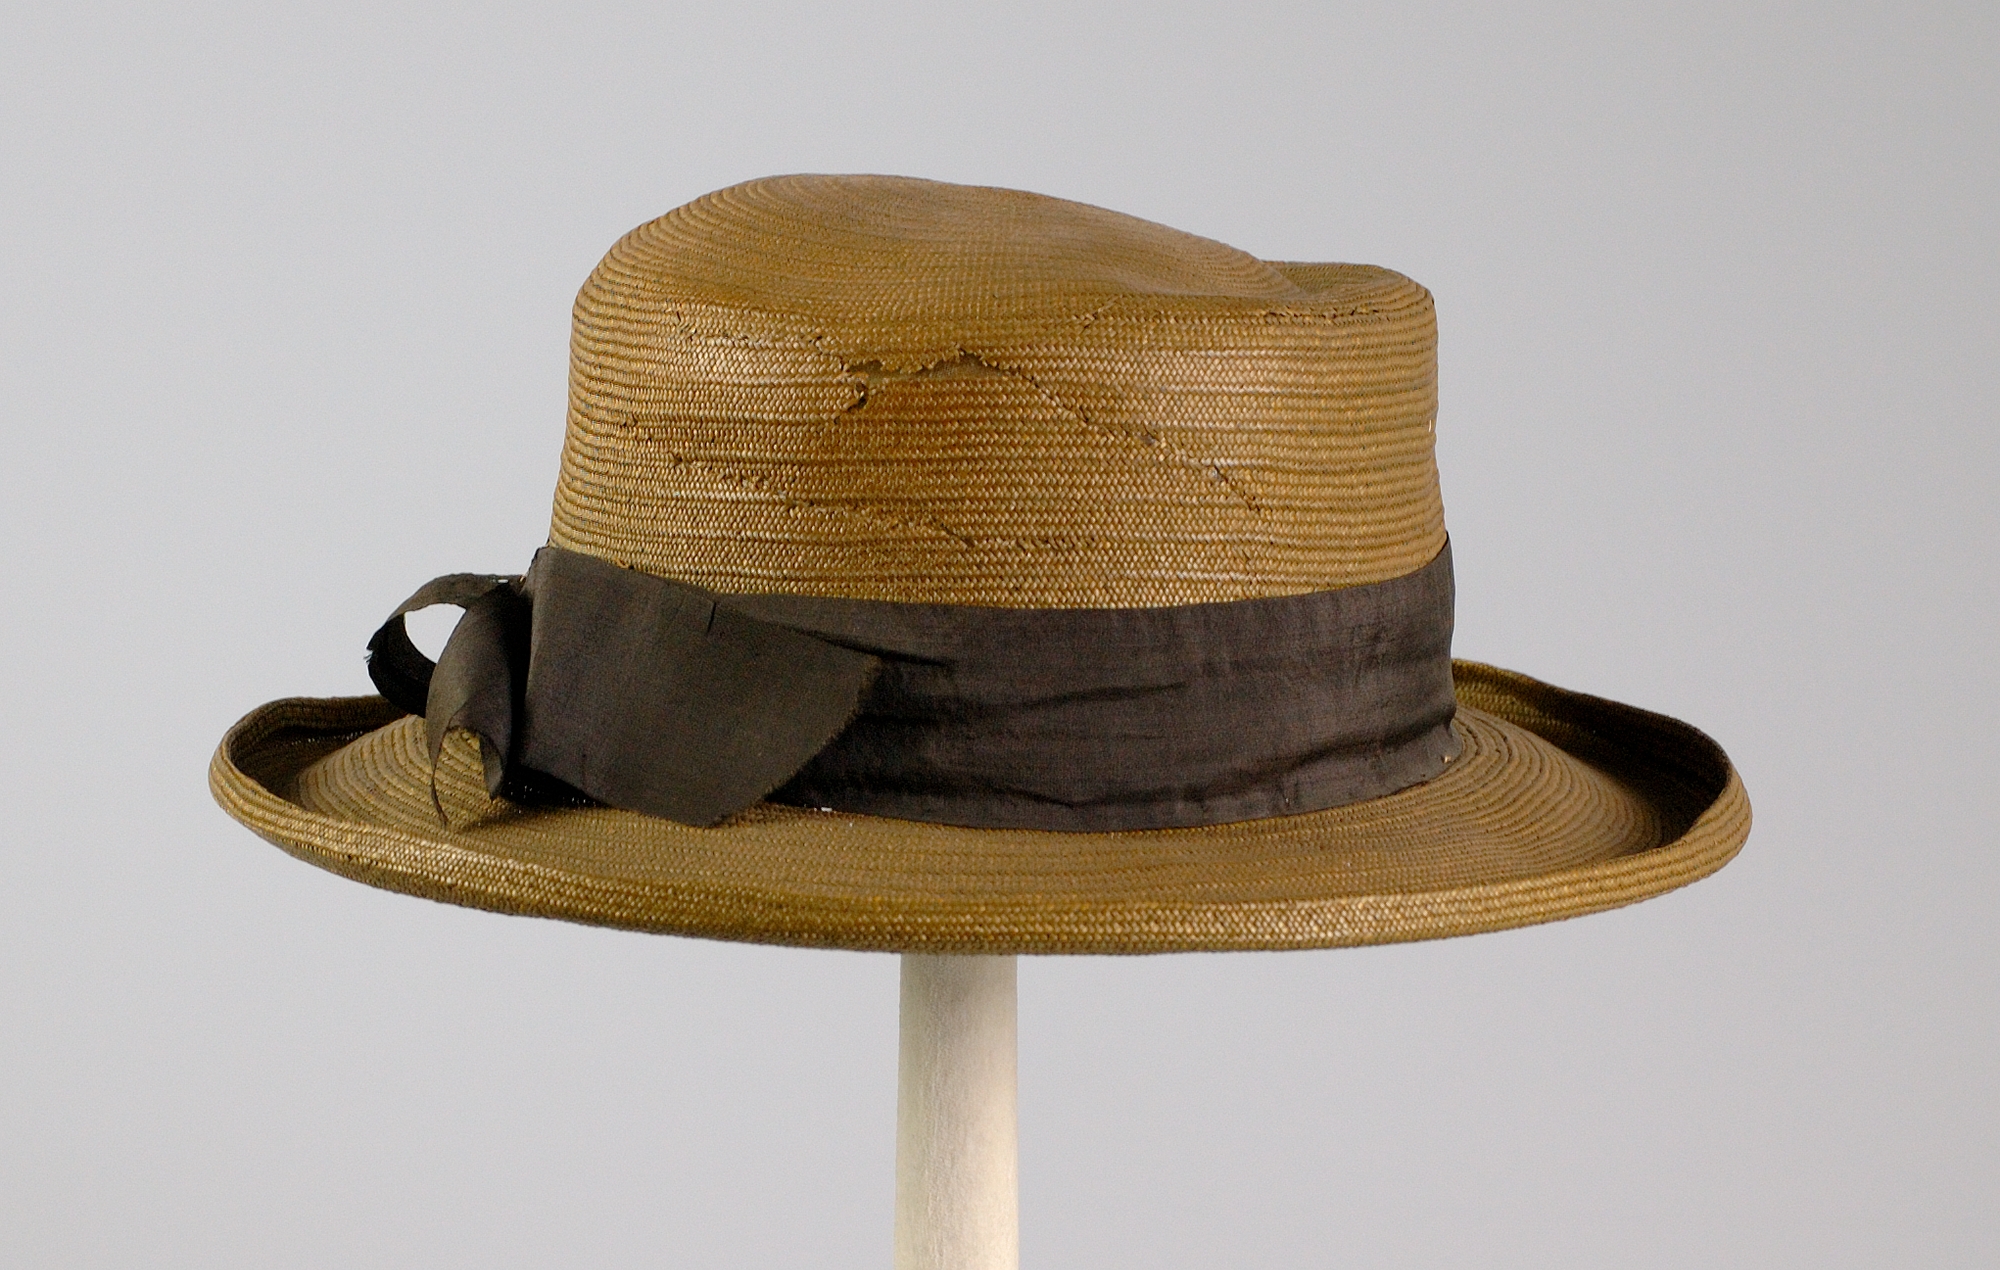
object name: sailor hat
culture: american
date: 1860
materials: silk, fiber